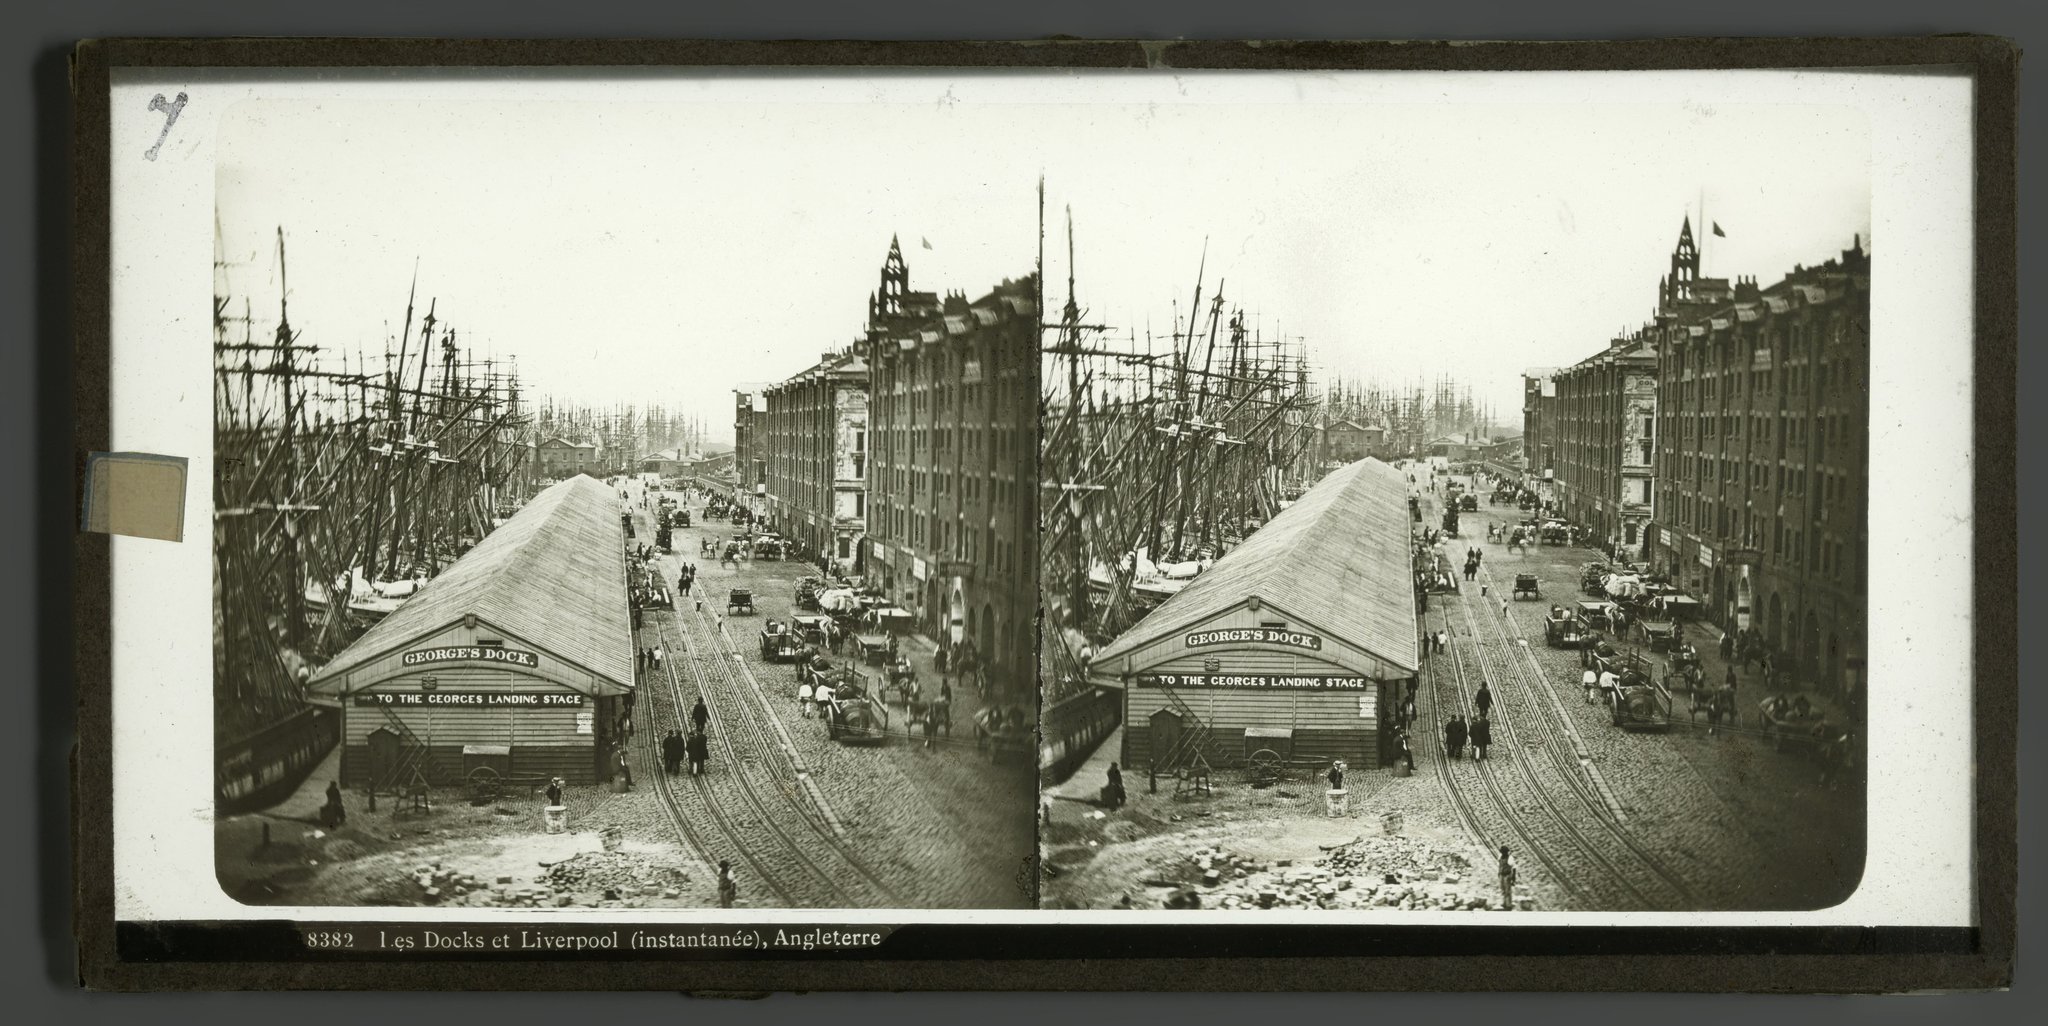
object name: stereoscopic photograph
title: Les Docks et Liverpool (instantanée), Angleterre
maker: Anonymous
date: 1860-1890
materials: glass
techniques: slide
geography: liverpool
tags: harbour, liverpool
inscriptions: number: ‘8382’